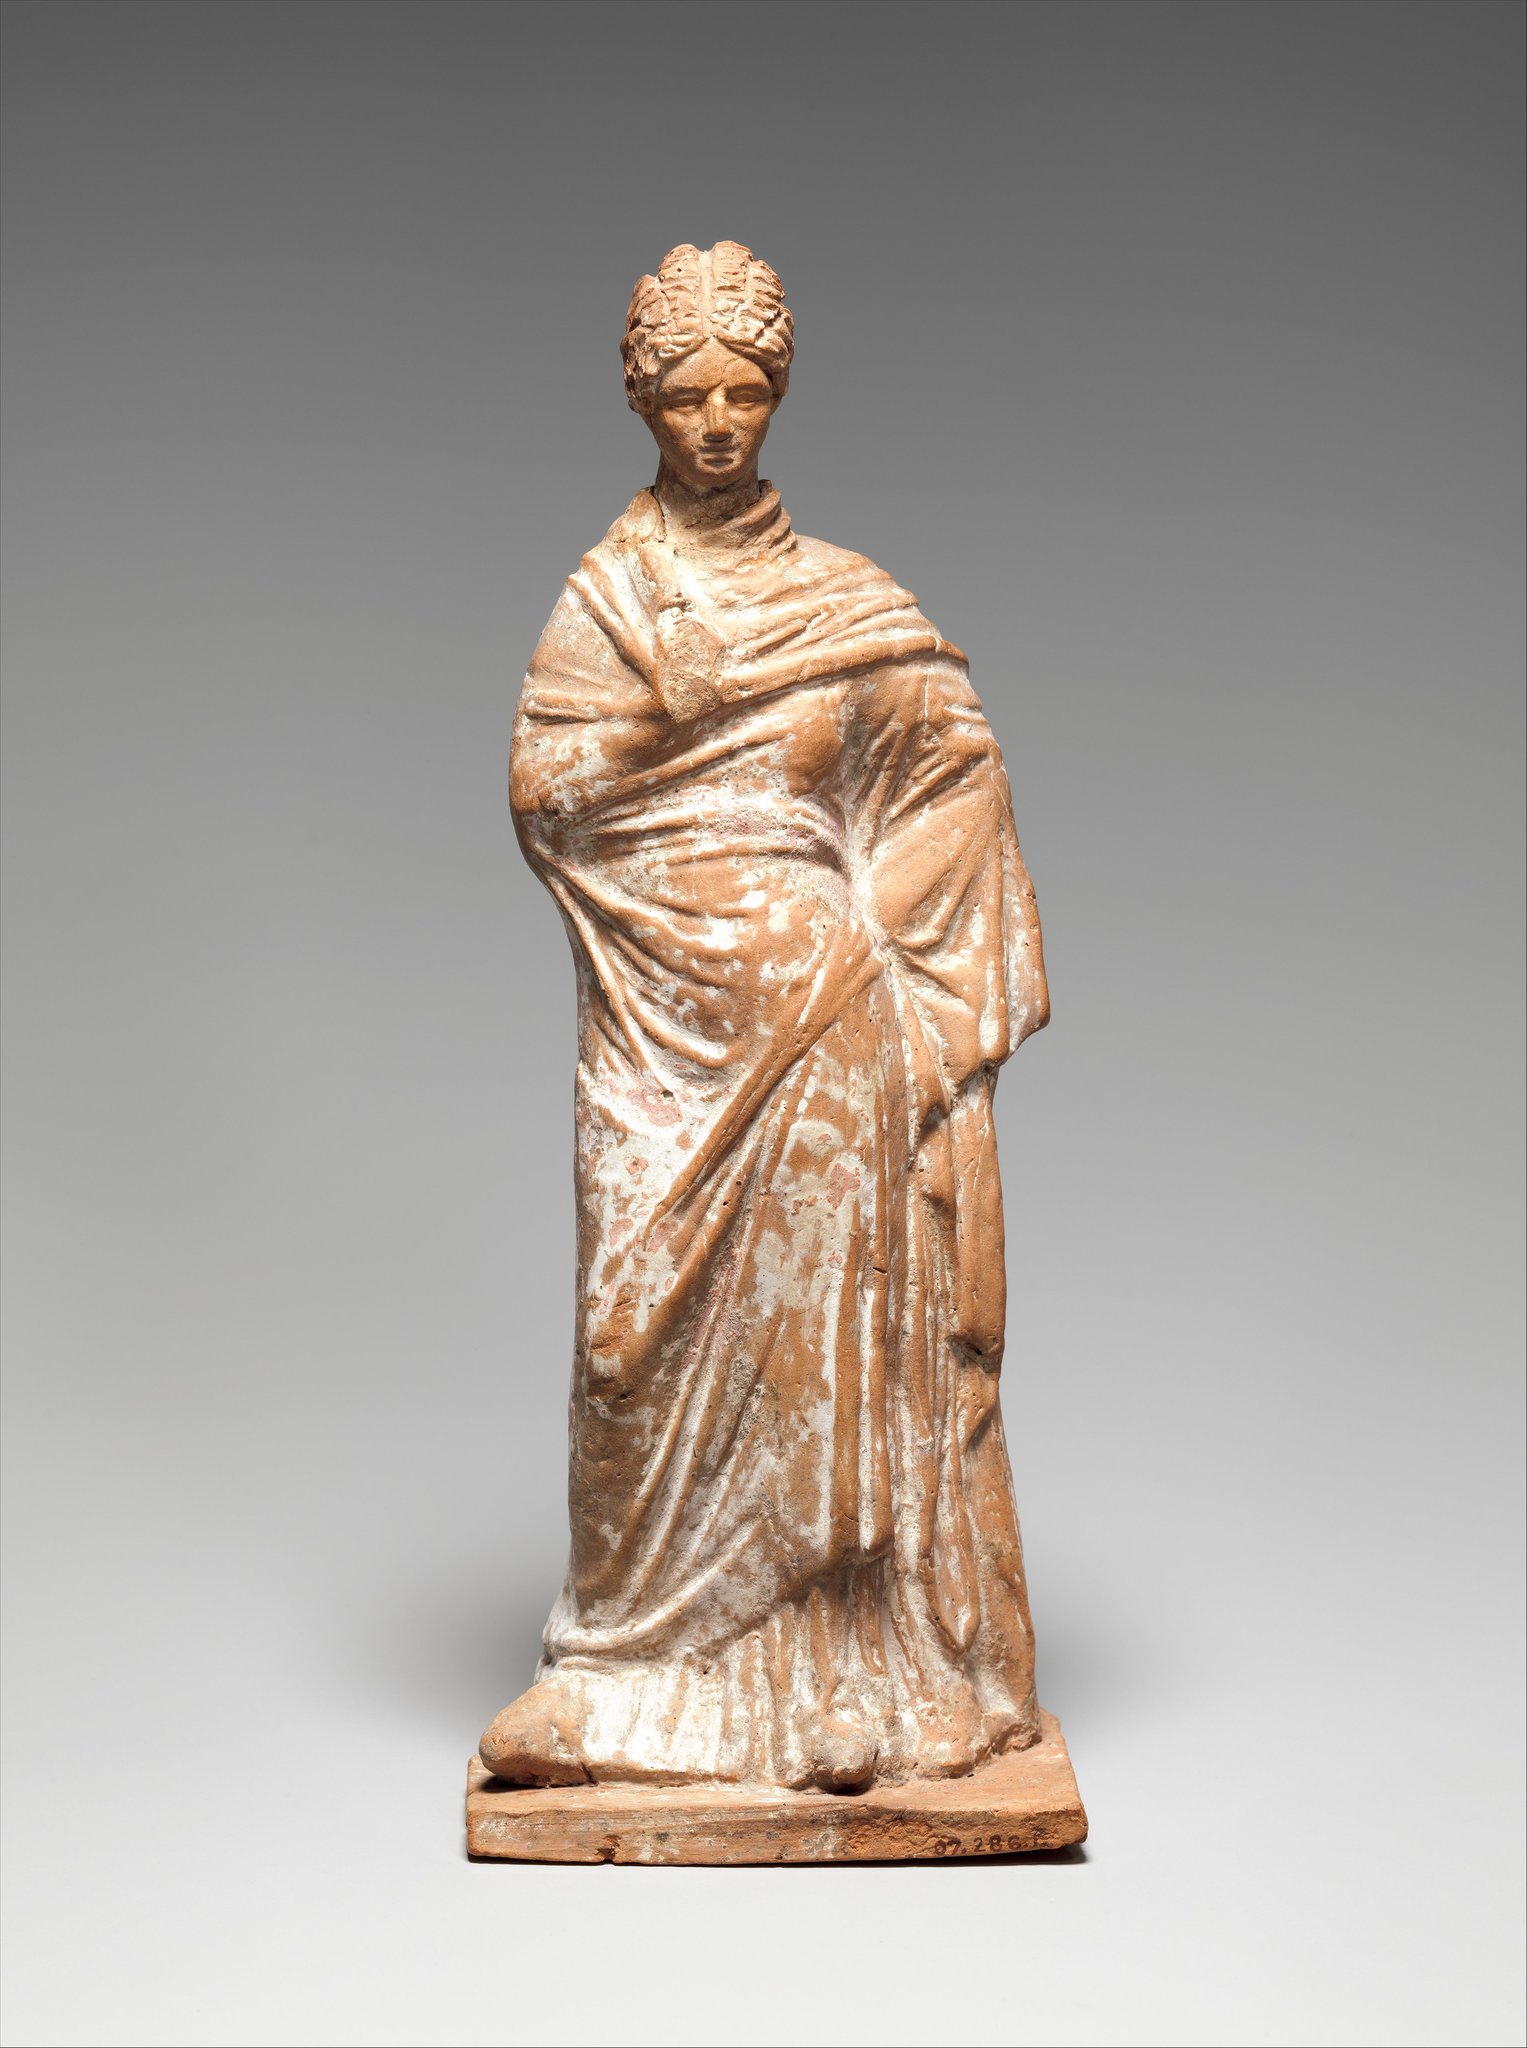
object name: statuette of a woman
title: Terracotta statuette of a standing woman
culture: greek, attic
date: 334-268 BCE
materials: terracotta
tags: women